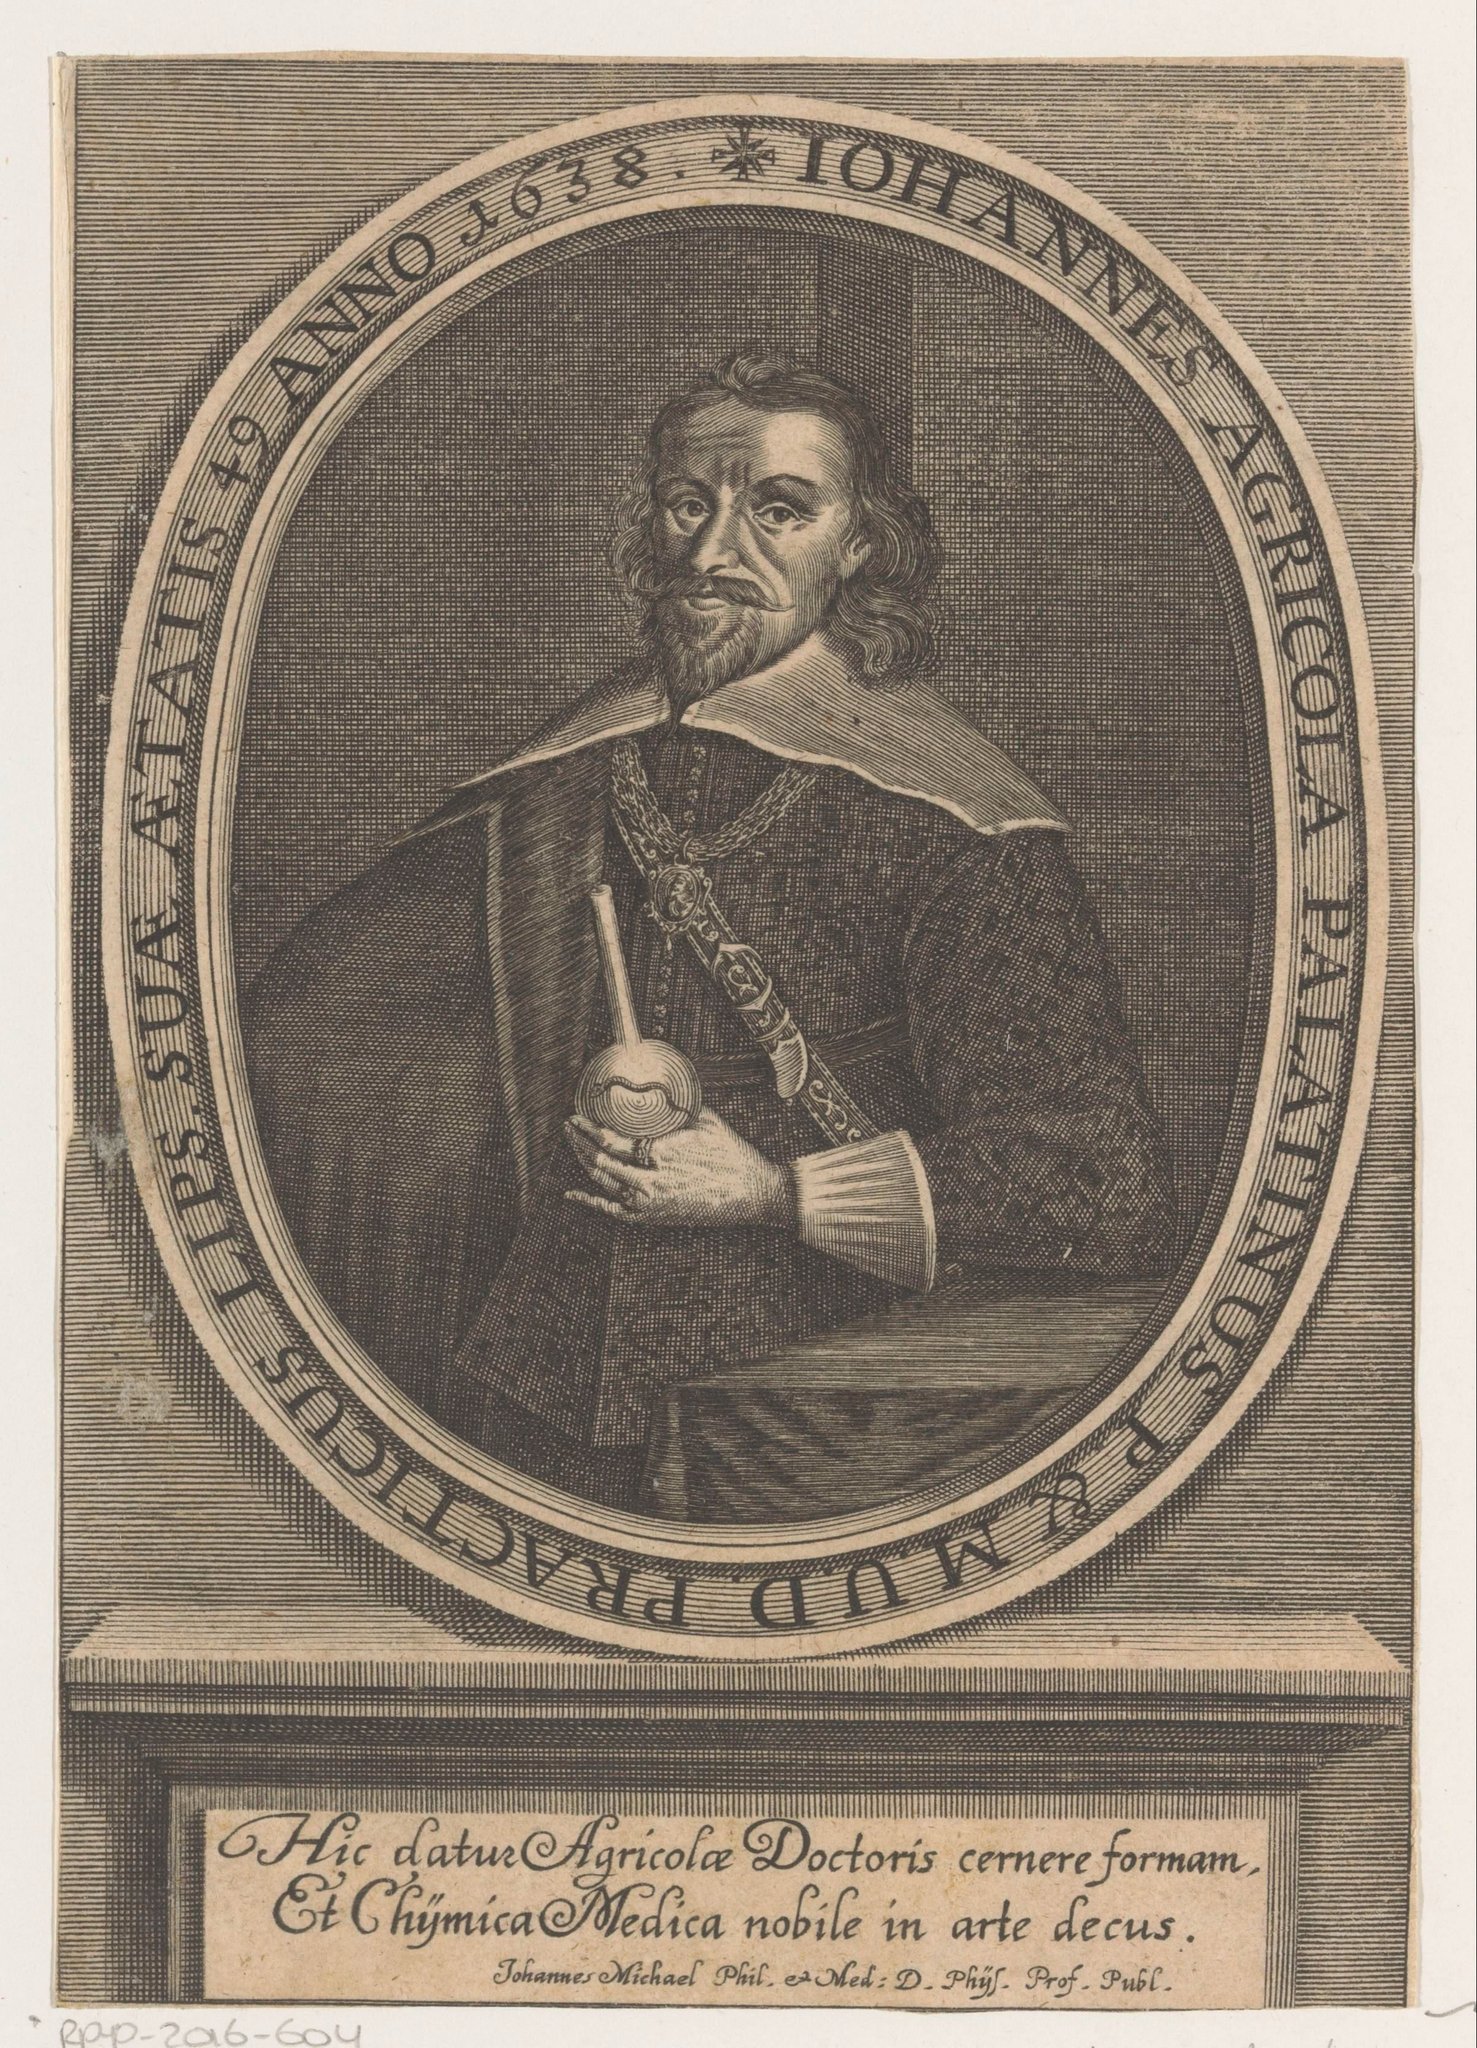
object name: print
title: Portret van Johannes Agricola II op 49-jarige leeftijd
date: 1638-1699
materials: paper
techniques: engraving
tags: beieren, breslau, alchemist, arts, johann agricola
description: Portret van Johannes Agricola II in een ovale omlijsting met randschrift. Hij heeft een distilleerkolf in zijn linkerhand. In een kader twee regels Latijnse tekst.